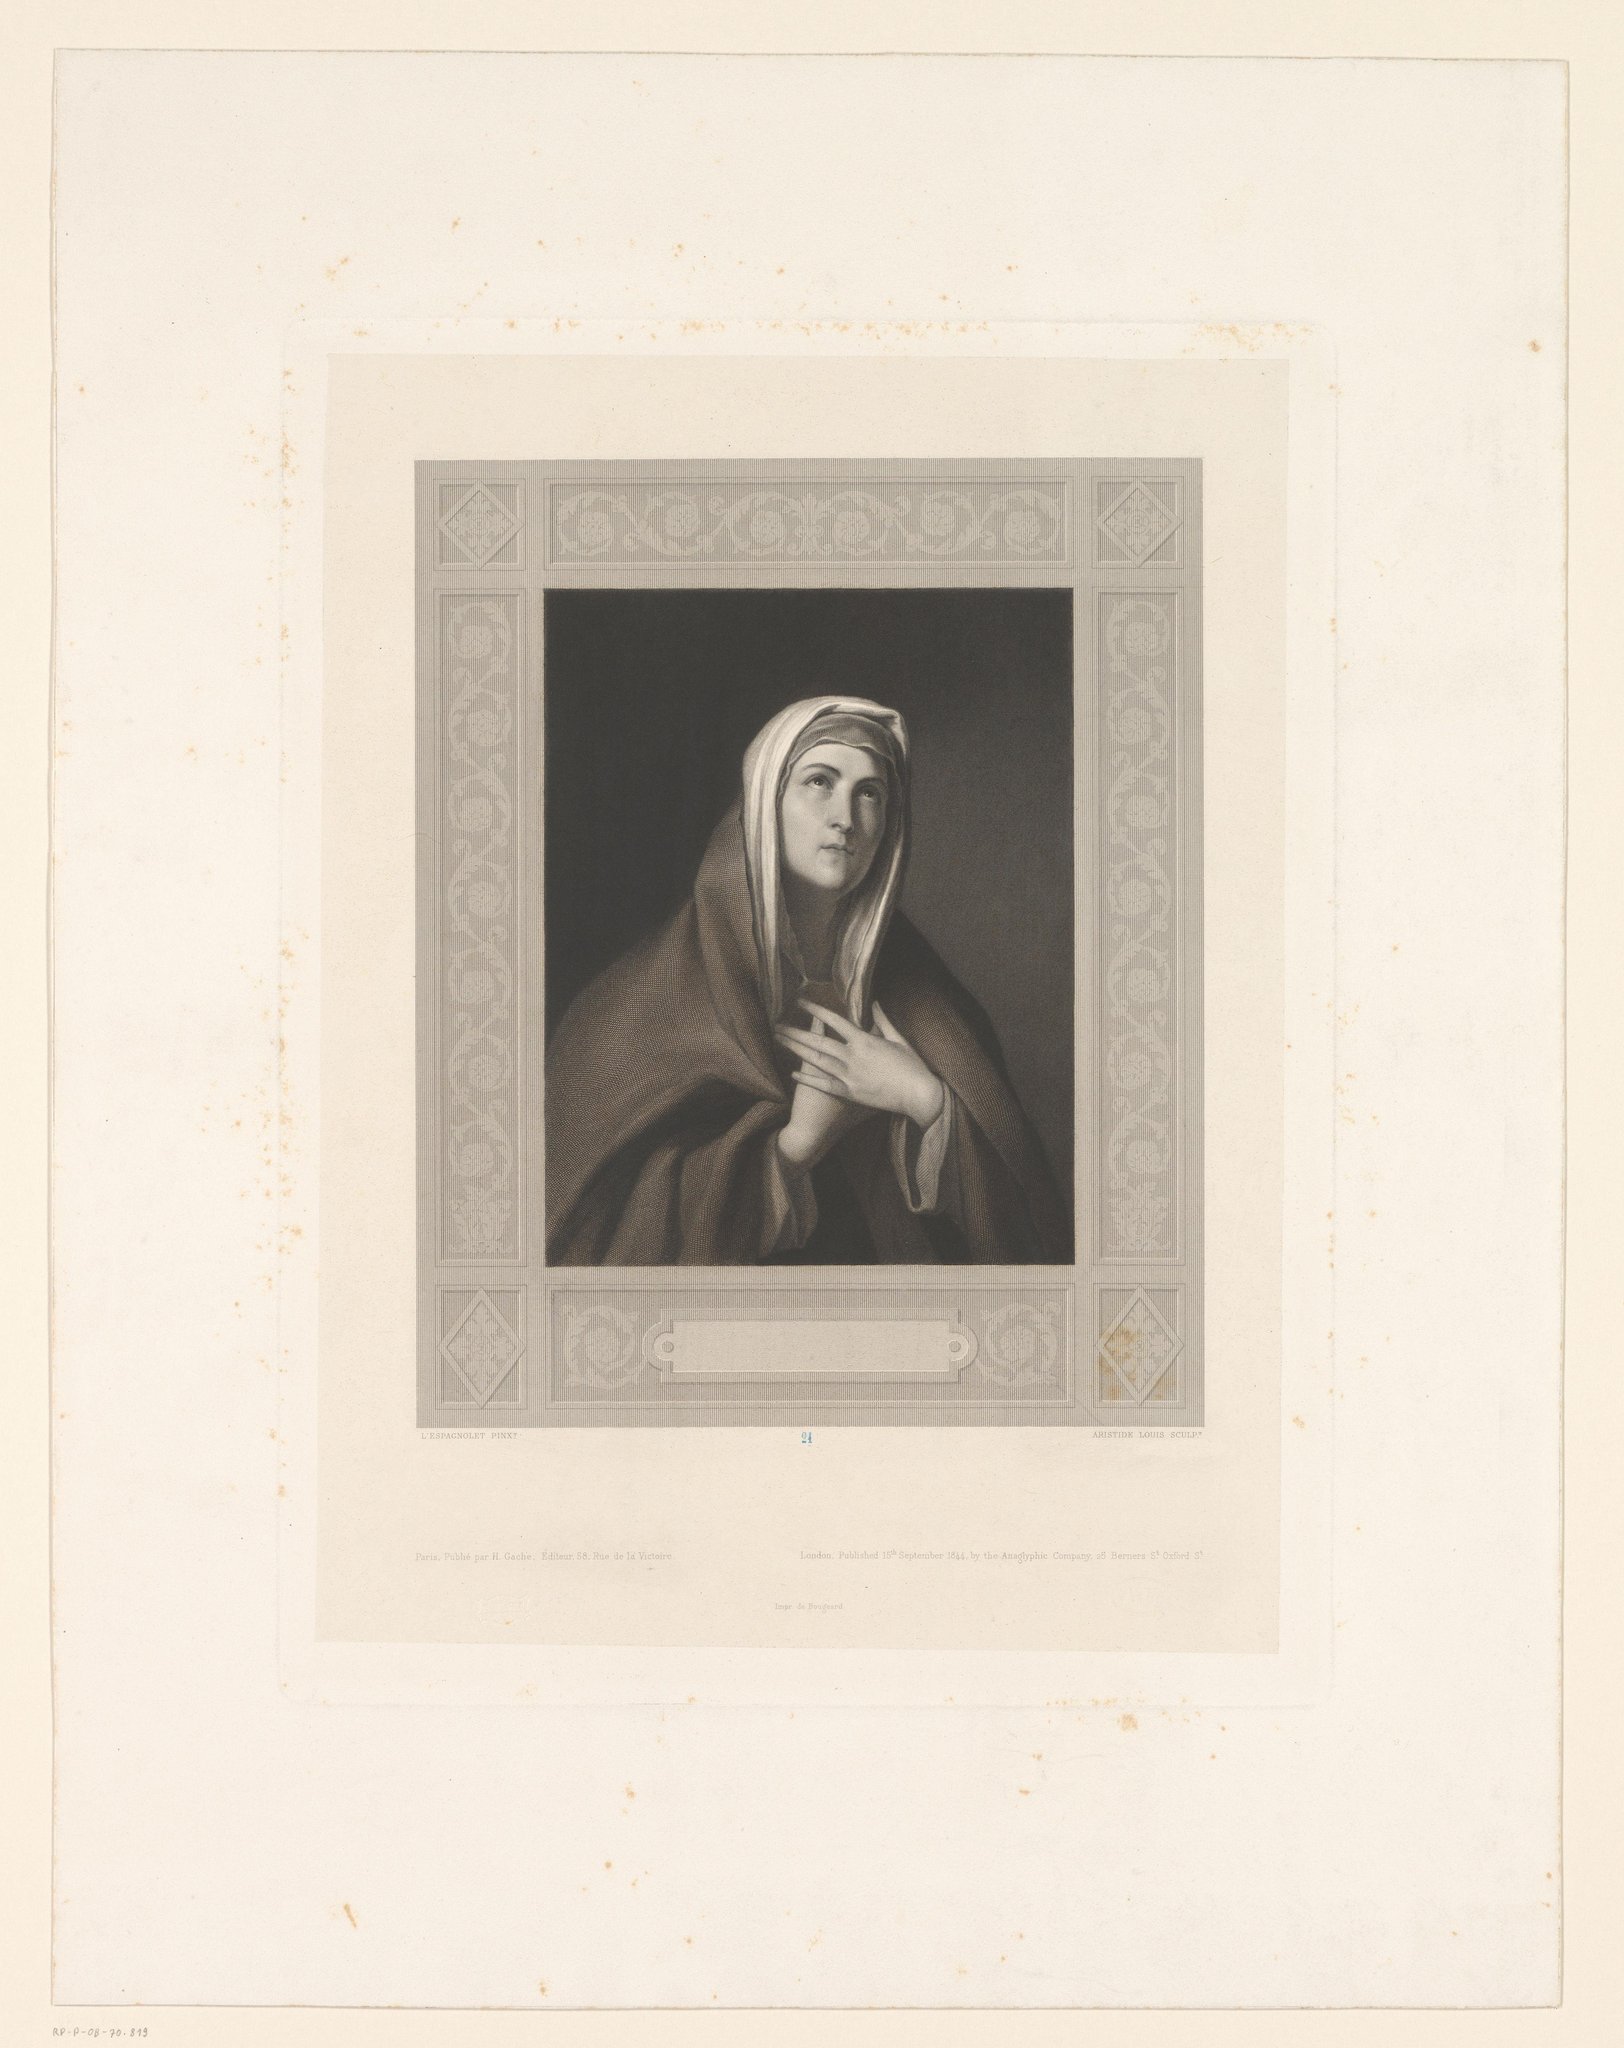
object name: print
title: Maria als Mater Dolorosa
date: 1844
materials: paper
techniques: engraving, etching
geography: paris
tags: mary weeping - ff - 'mater dolorosa', head or bust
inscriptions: check stamp: Lugt 3979, collector's mark: Lugt 12, check stamp: Lugt 3977